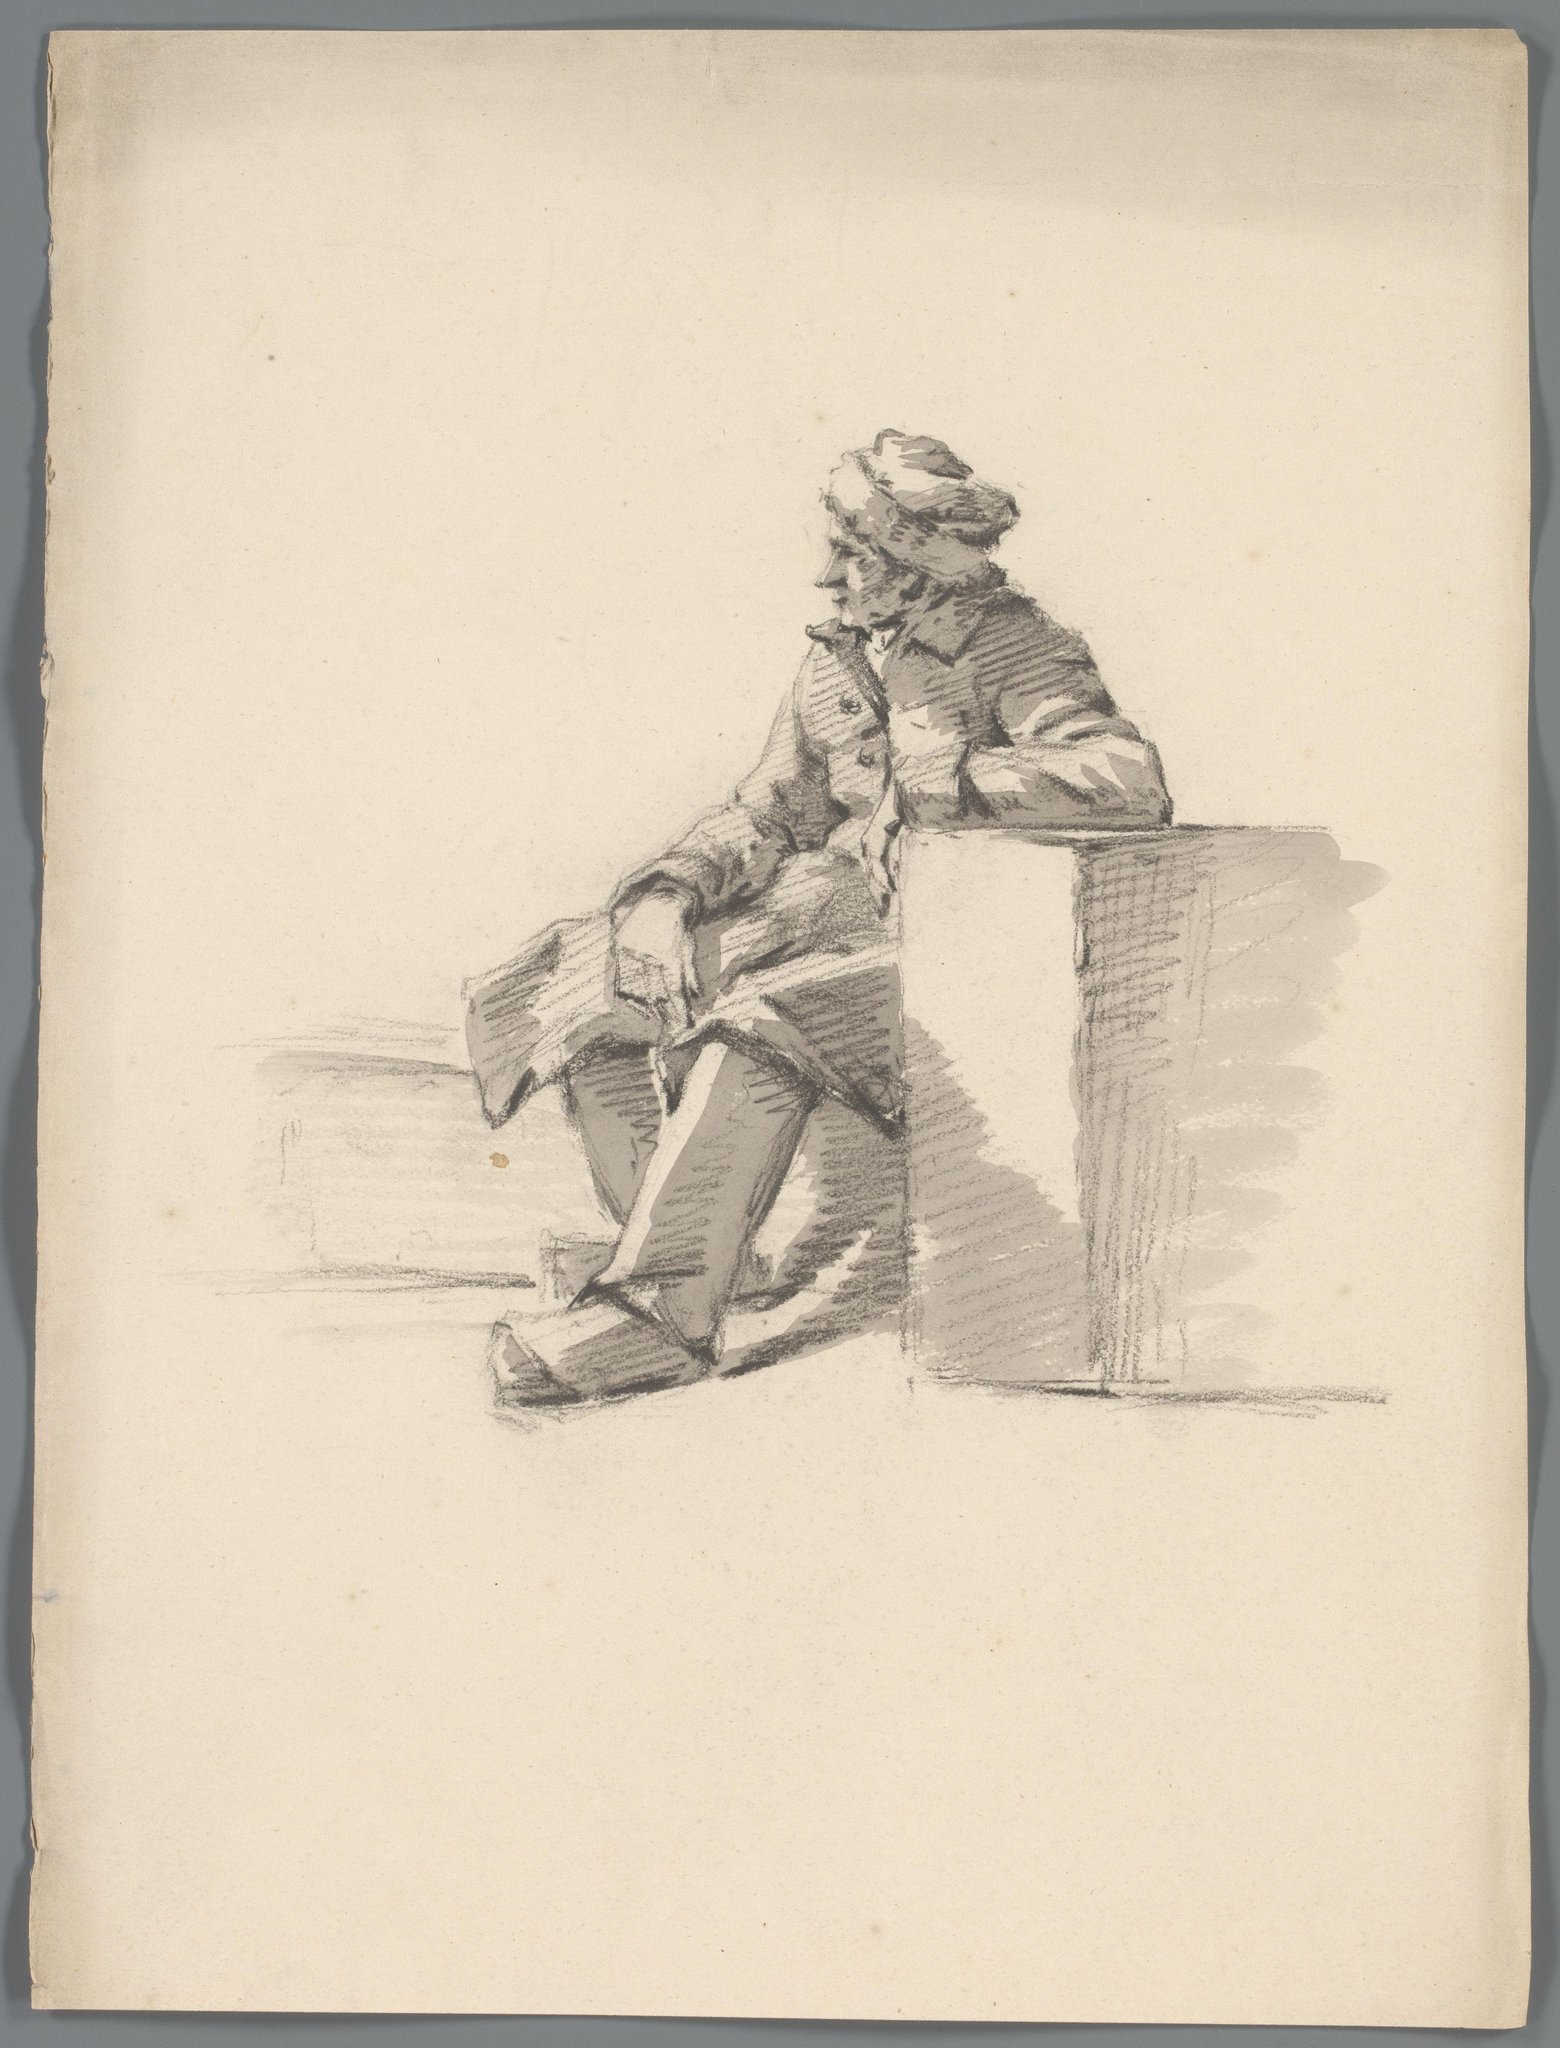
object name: drawing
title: Zittende man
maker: Anonymous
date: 1820-1830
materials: chalk, paper, watercolor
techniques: brush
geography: the hague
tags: sitting figure, adult man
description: Tekeningen waarschijnlijk ontstaan bij het Haagse kunstgenootschap ‘Tot Nut der Tekenkunst’, waar twee keer per week tekenavonden werden georganiseerd met geklede modellen.